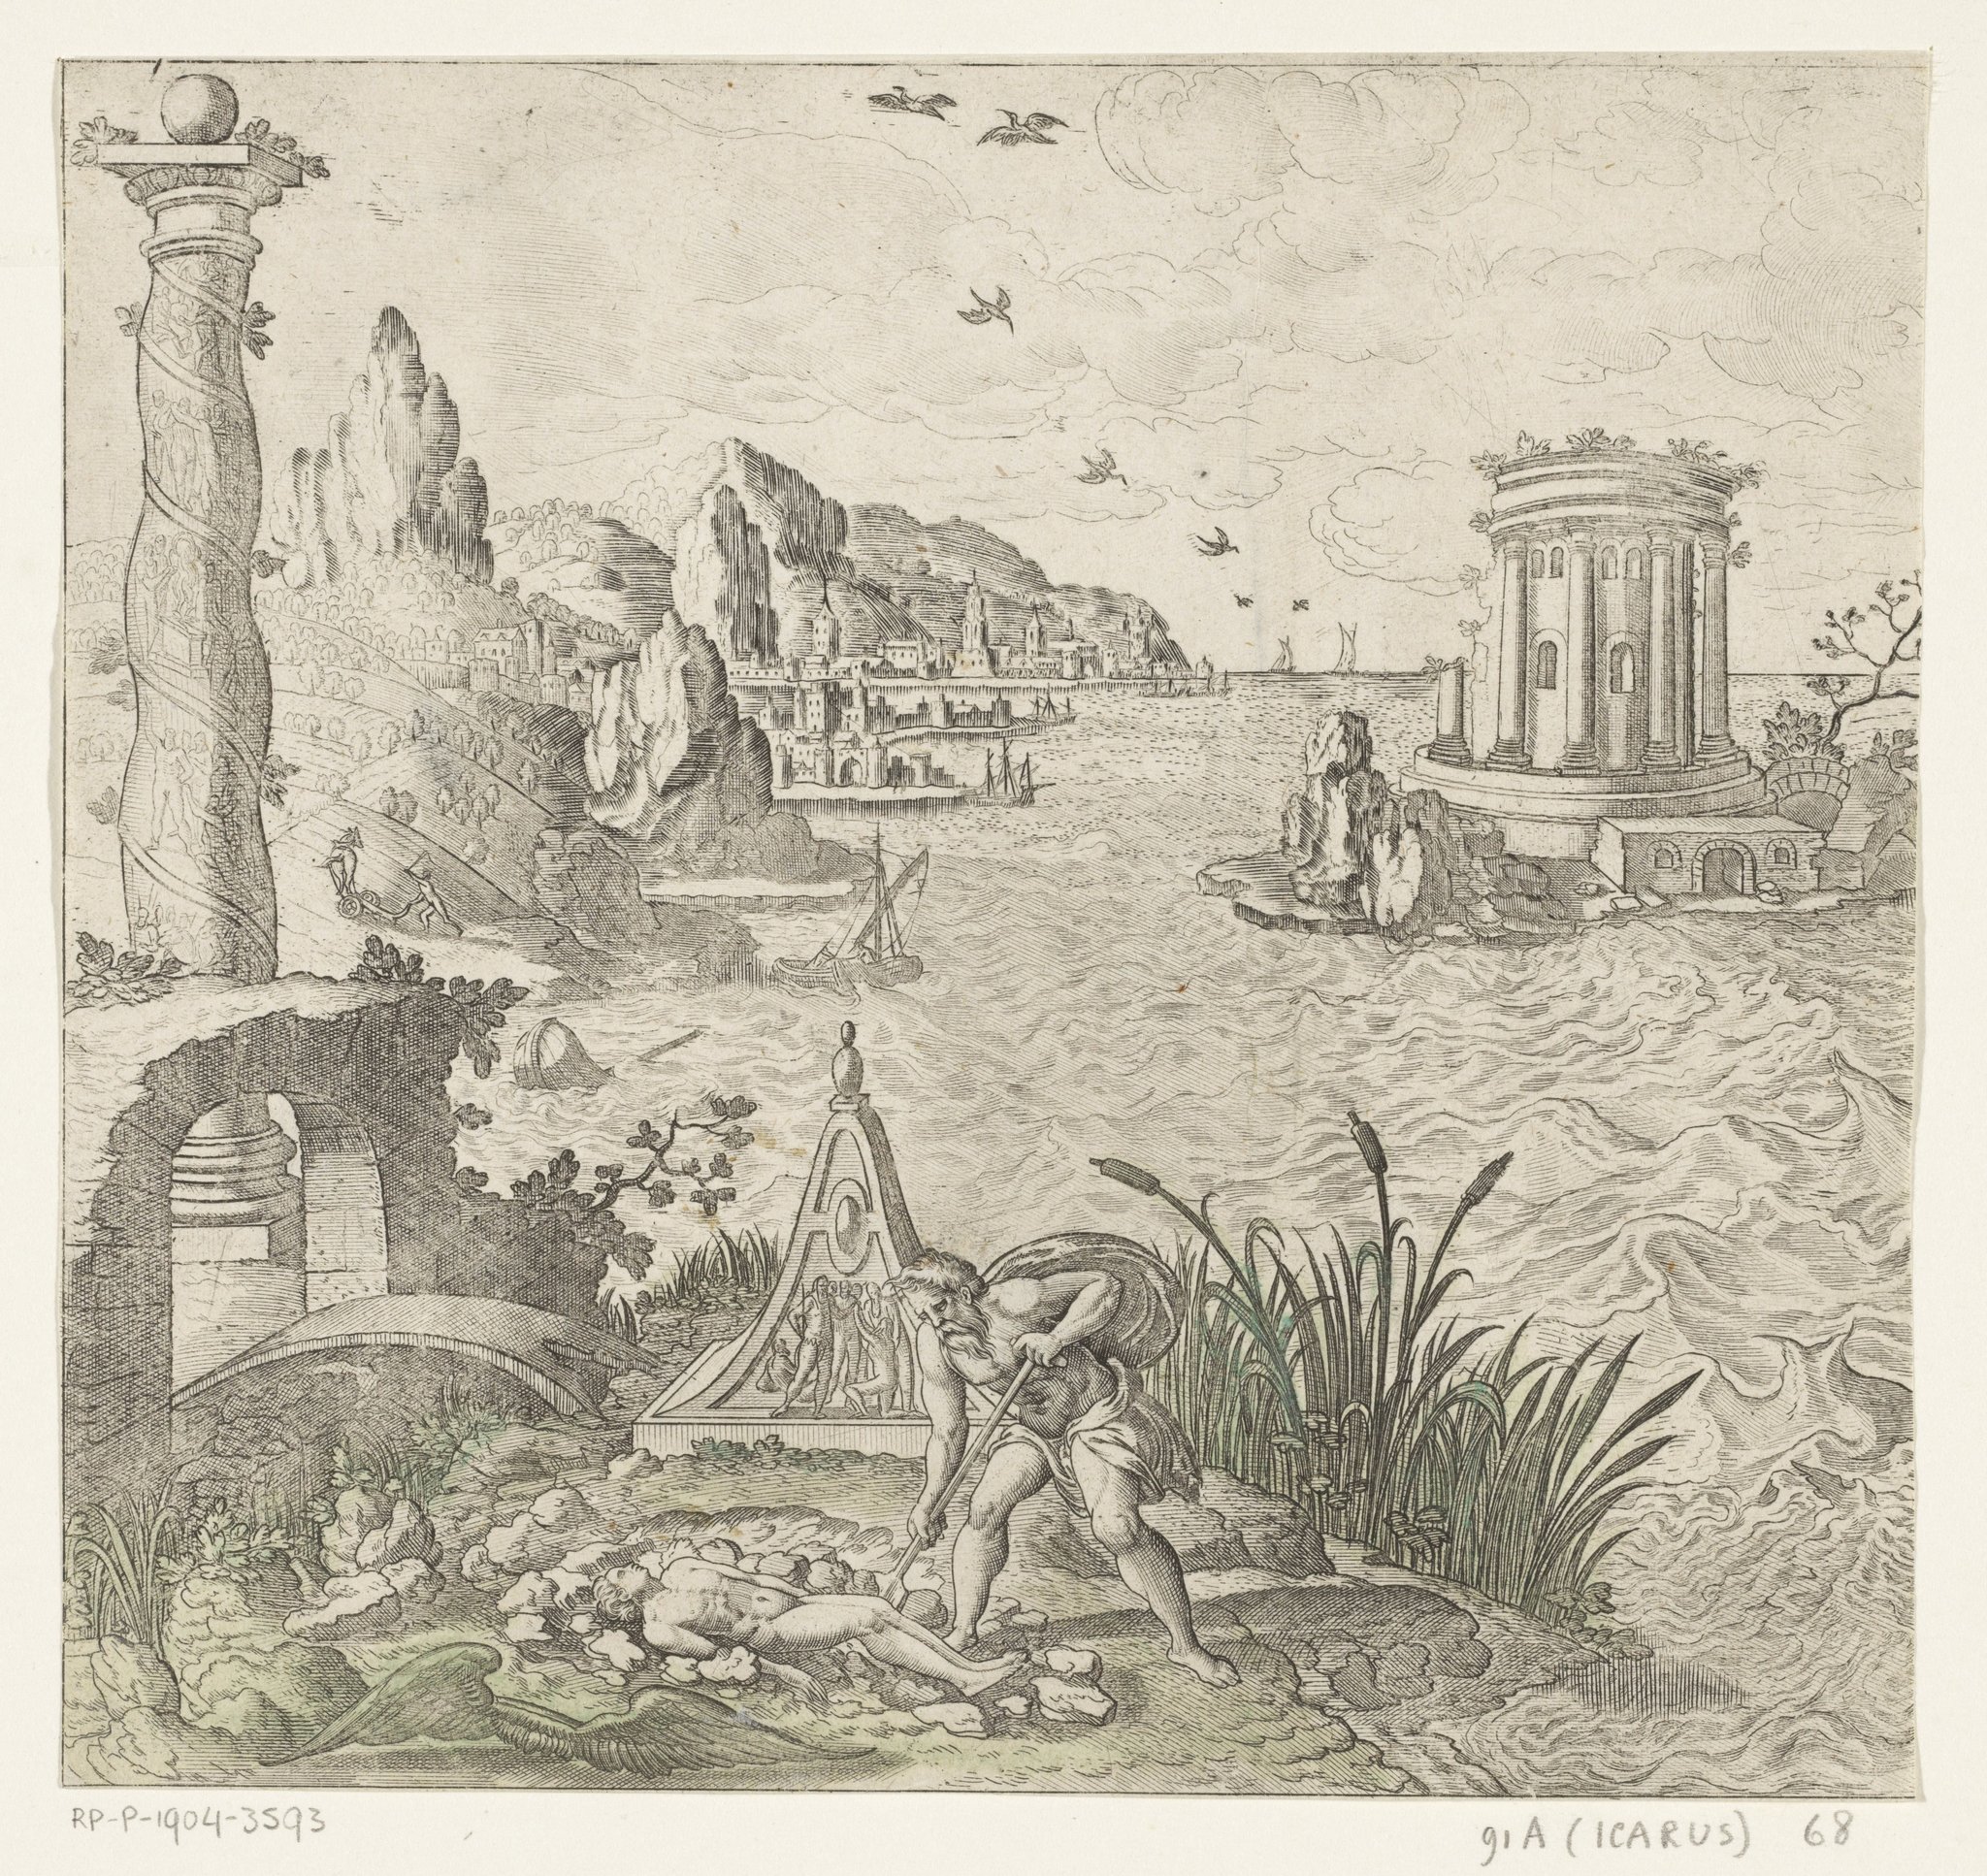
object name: print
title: Daedalus en Icarus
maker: johannes of lucas van doetechum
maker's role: print maker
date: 1572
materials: ink, paper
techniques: etching, pen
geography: antwerp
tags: death i.e. the fall of icarus (daedalus present), (story of) icarus, son of daedalus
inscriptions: collector's mark: Lugt 2228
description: Daedalus en Icarus, vader en zoon, ontsnappen van het eiland Kreta met vleugels die met was aan hun schouders zijn vastgezet waardoor ze kunnen vliegen. Icarus vliegt echter te hoog waardoor de zon de was doet smelten. Links op de voorgrond begraaft Daedalus zijn zoon Icarus.